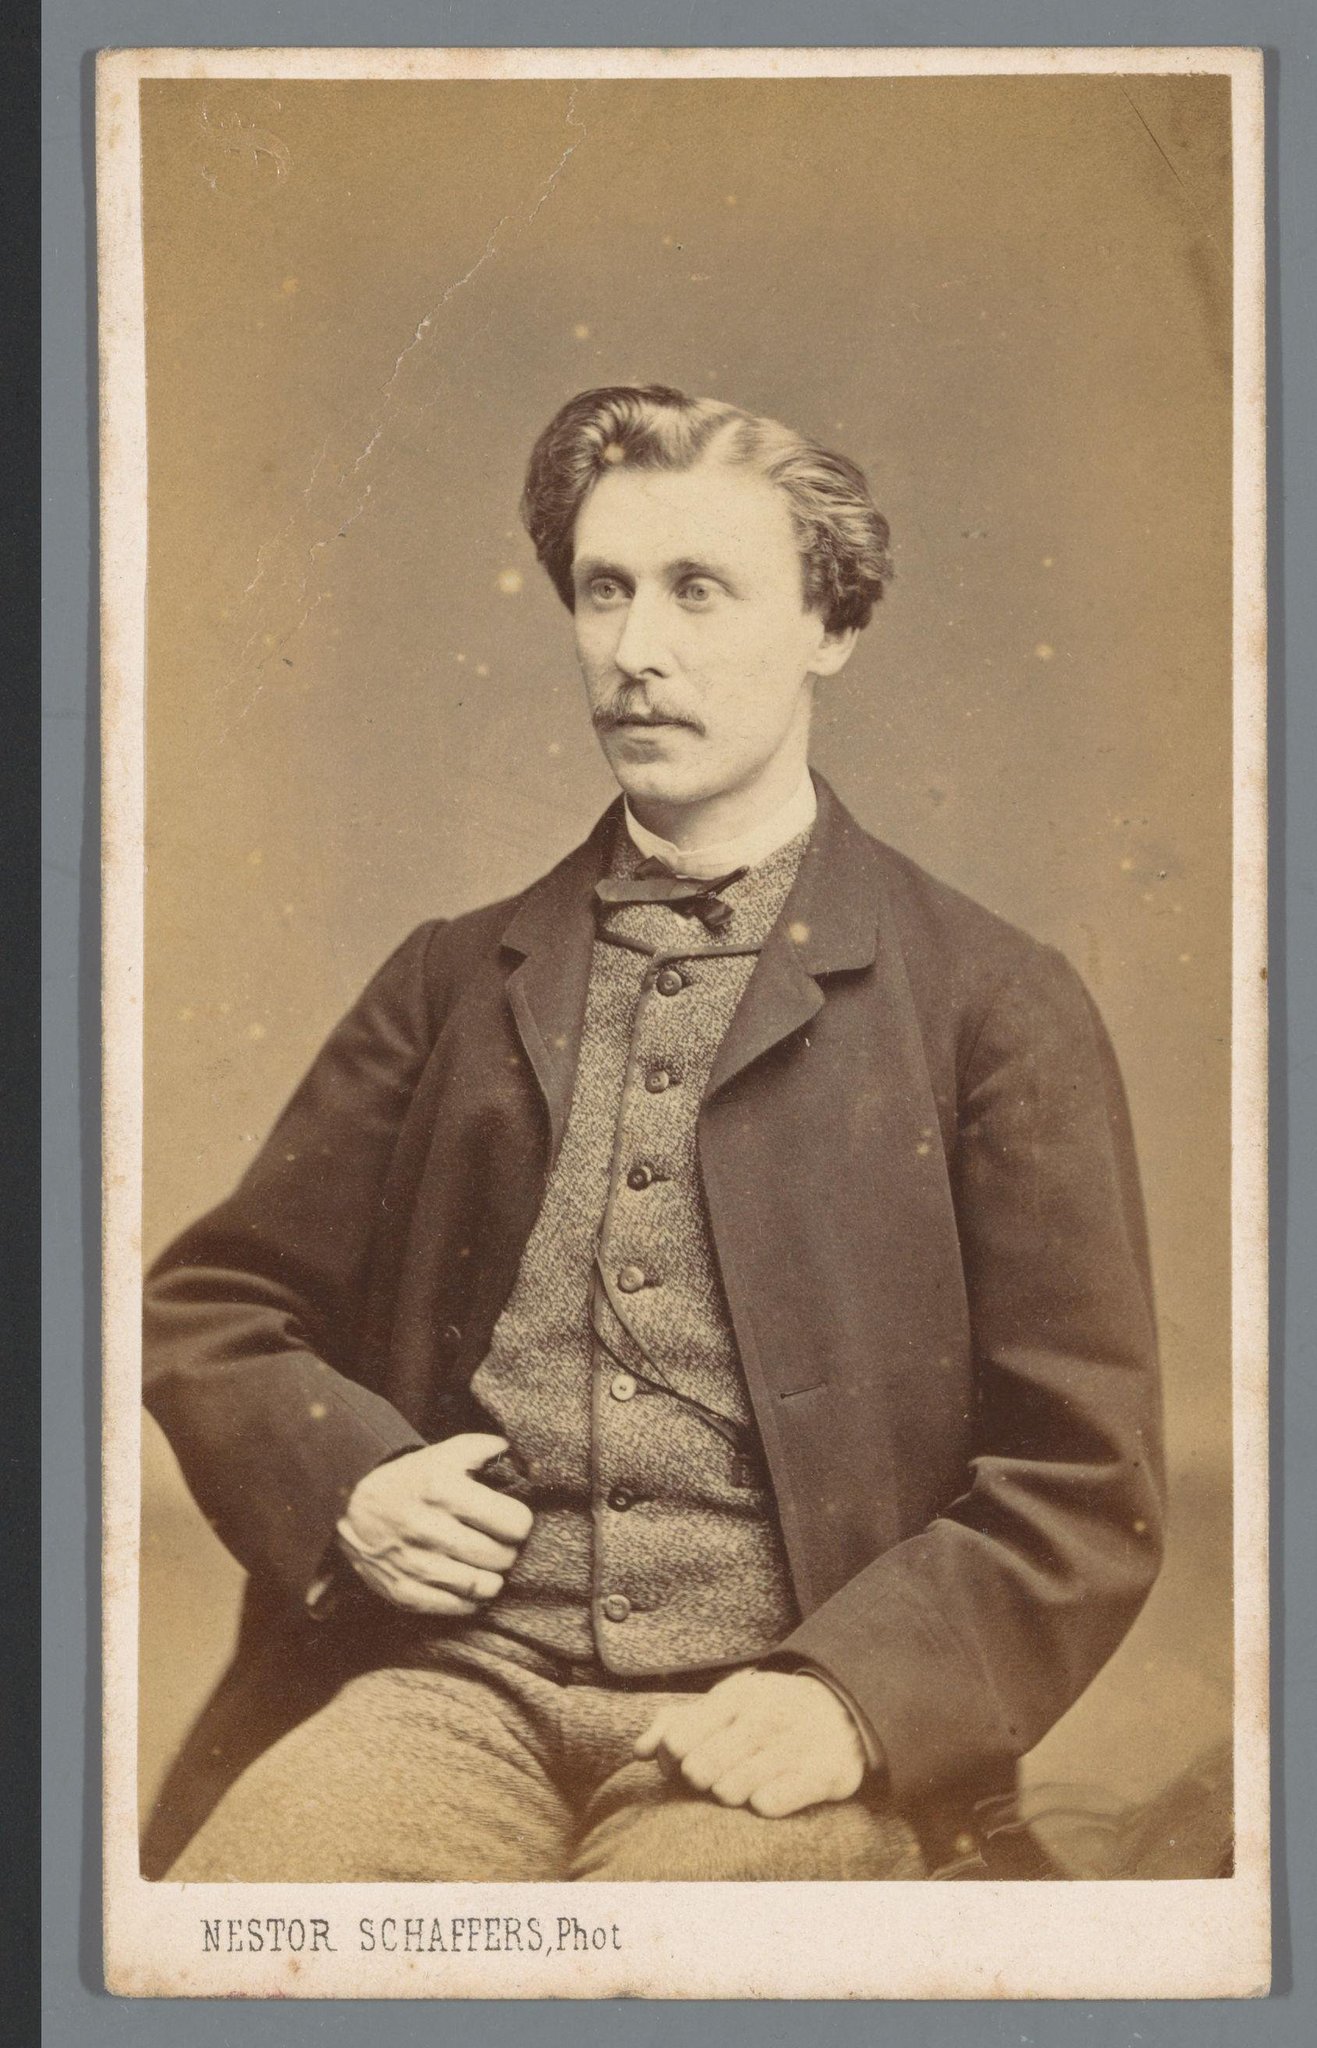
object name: carte de visite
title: Portret van een onbekende man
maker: paul joseph nicolas nestor schaffers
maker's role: fotograaf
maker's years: 1826-1896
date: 1862-1874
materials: cardboard, paper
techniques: albumen print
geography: ghent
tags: adult man, anonymous historical person portrayed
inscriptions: address: ‘GAND/ RUE DU PONT MADOU, 15’